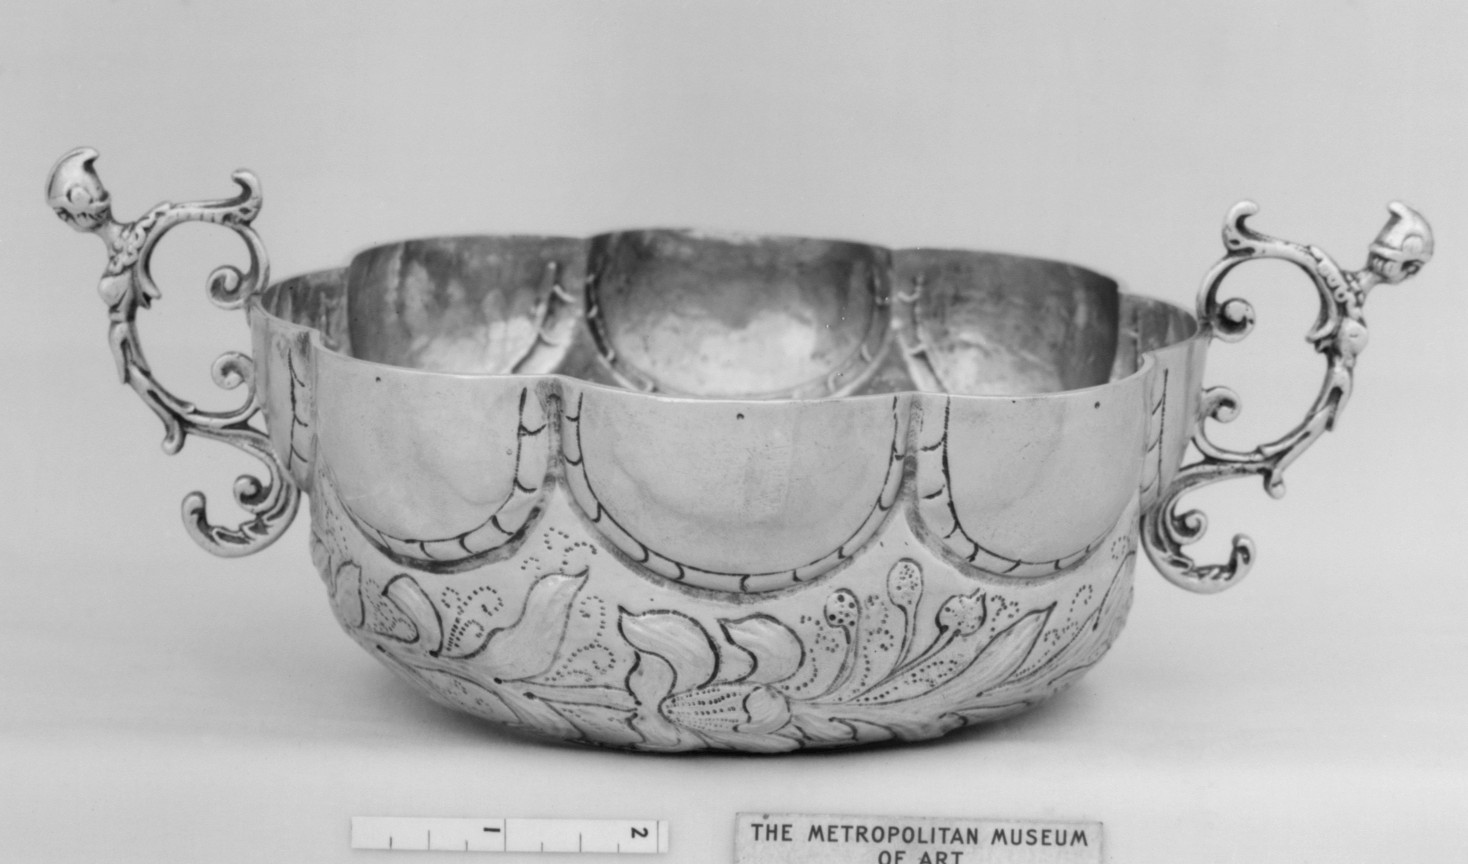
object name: bowl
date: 1651-1700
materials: silver